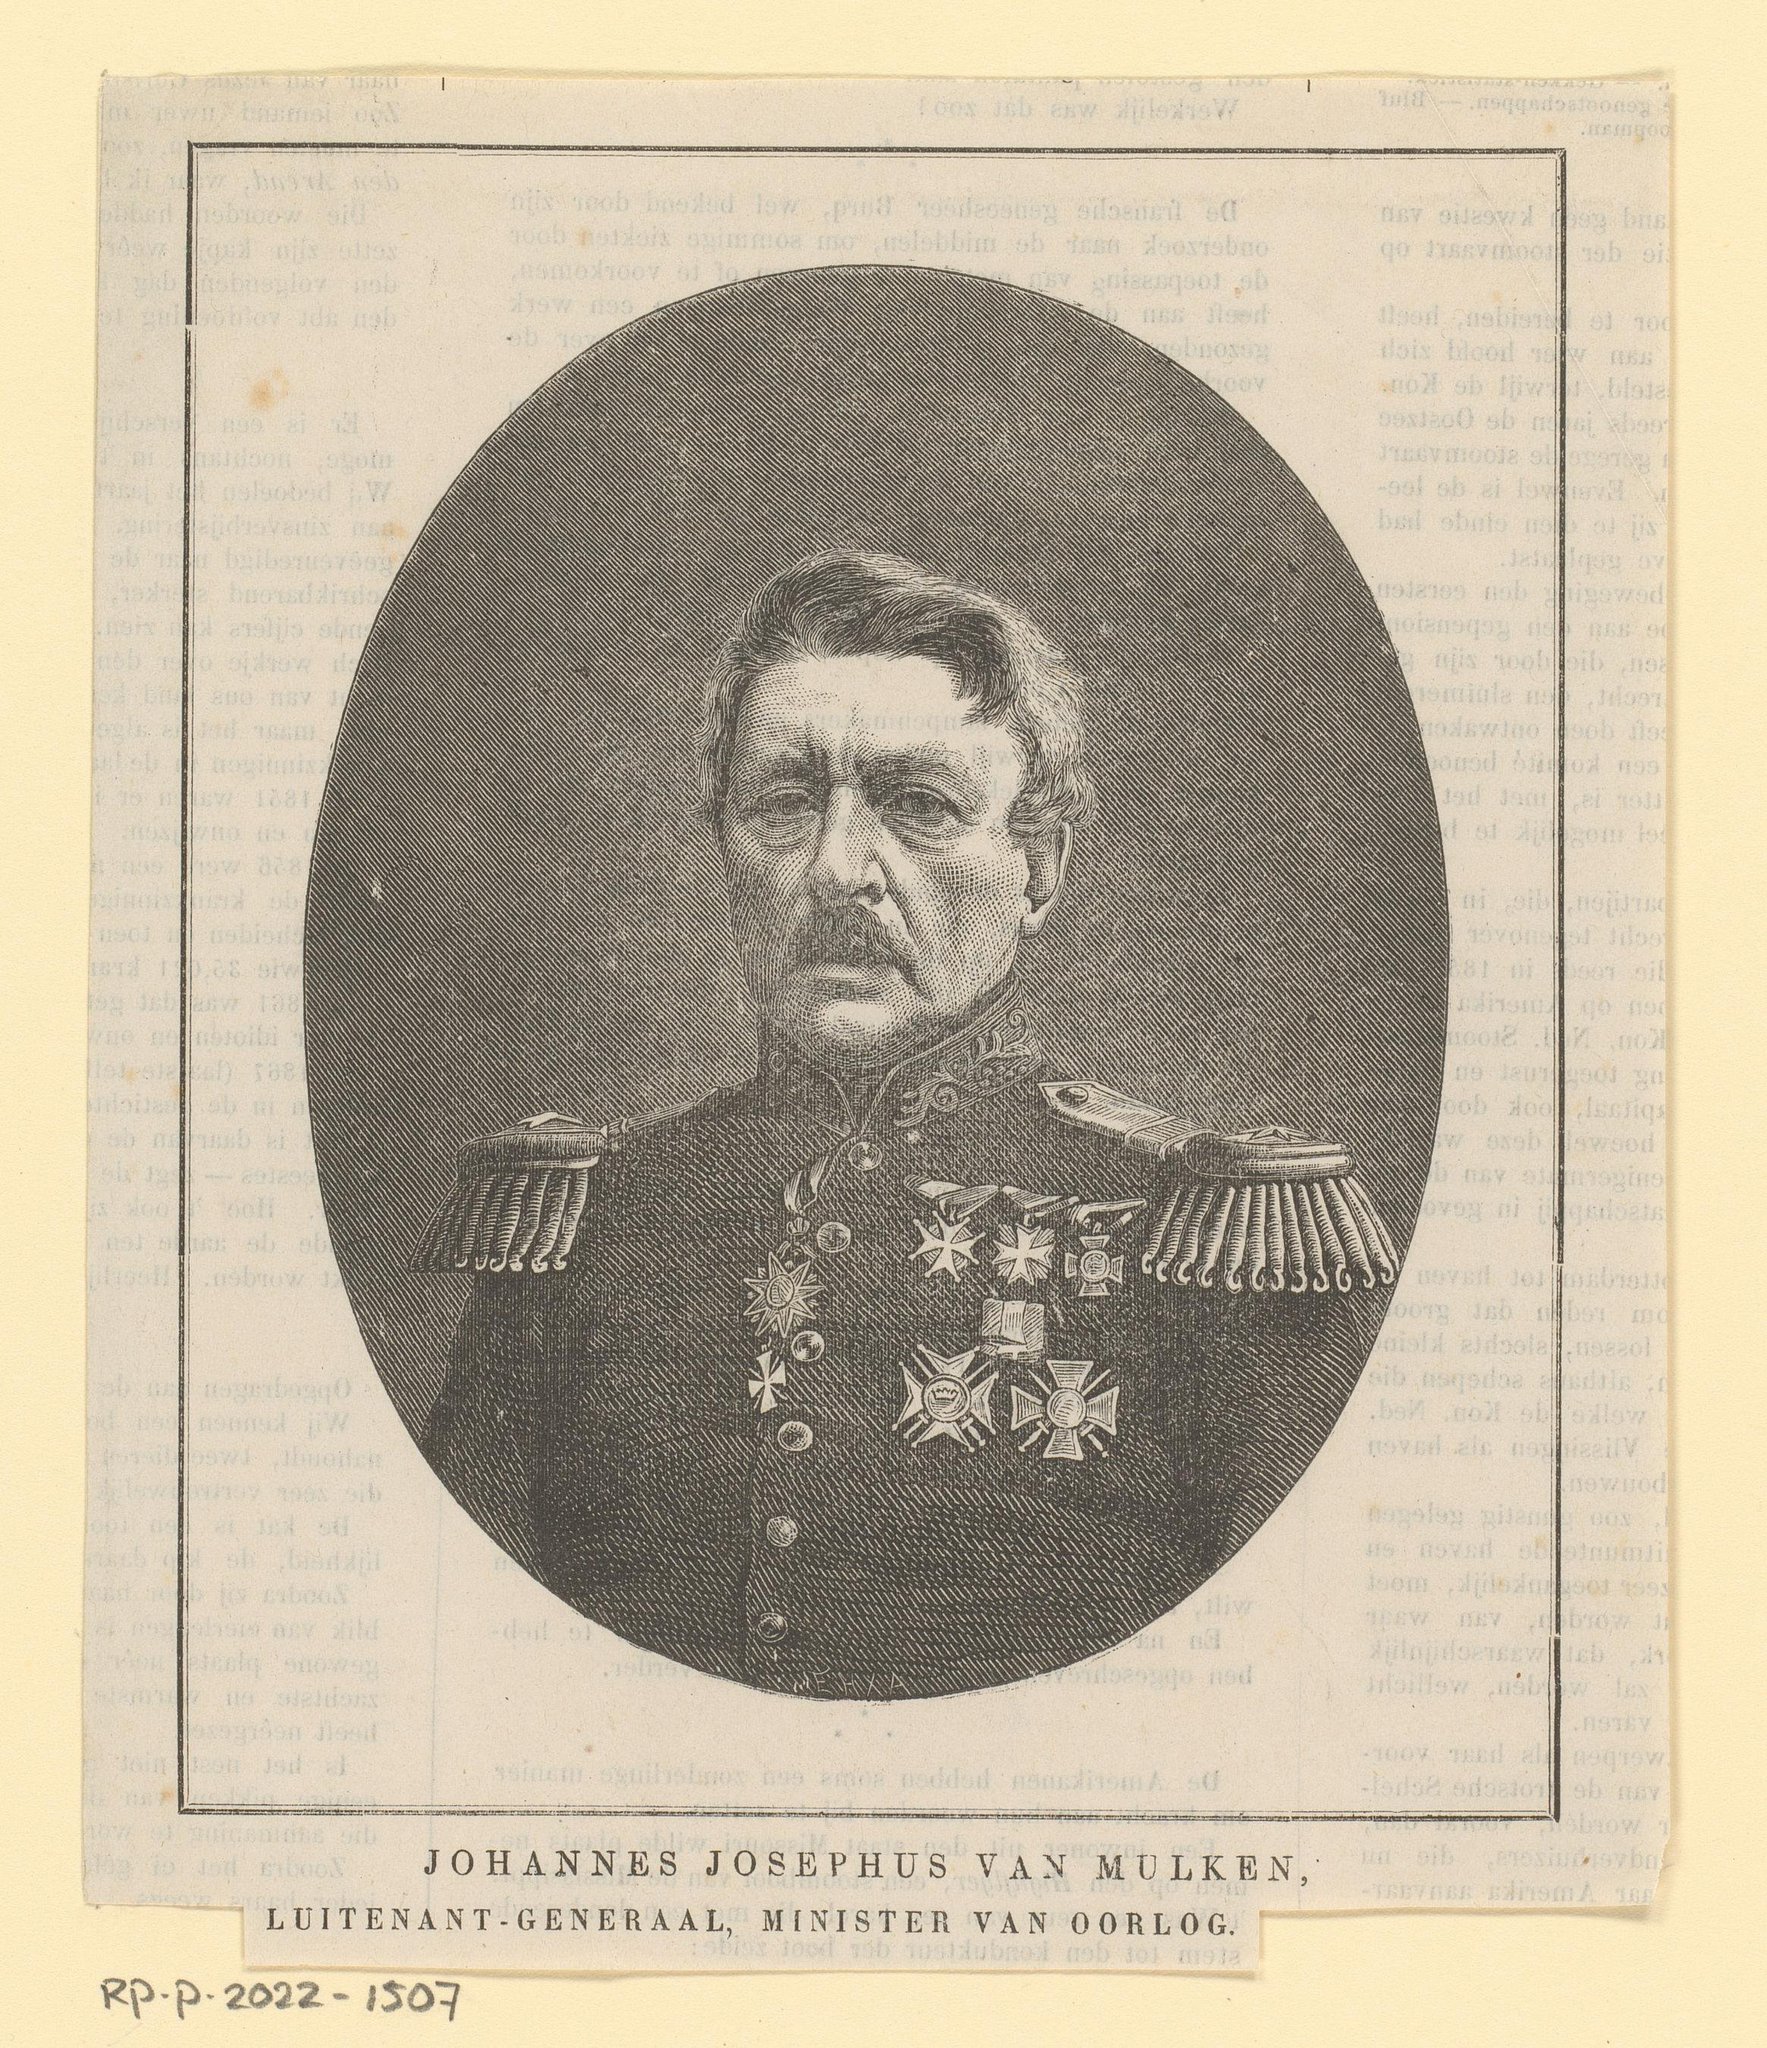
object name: print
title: Portret van Joannes Josephus van Mulken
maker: monogrammist eh (graveur)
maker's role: print maker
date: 1868-1900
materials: paper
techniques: letterpress printing, engraving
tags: commander-in-chief, general, marshal, historical persons